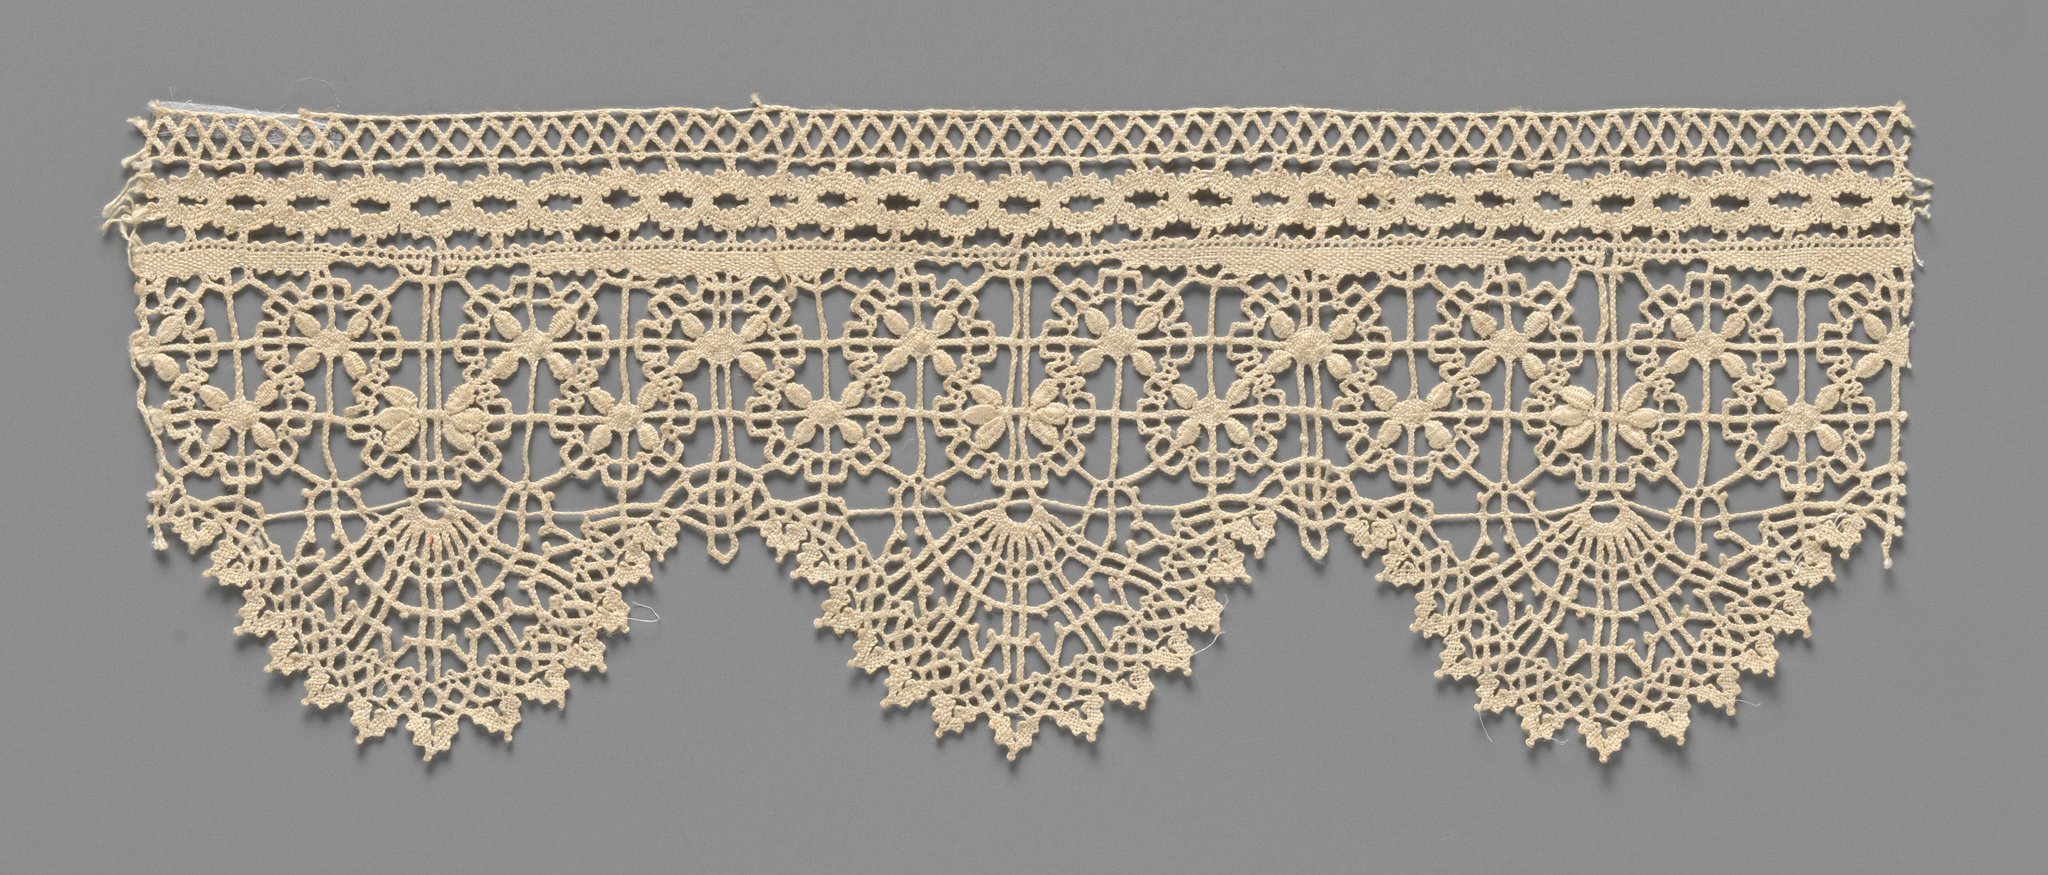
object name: strip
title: Strook kloskant met met gierstkorrelblaadjes in vierkant raster en waaiervormige schulpen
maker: Anonymous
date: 1925-1936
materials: linen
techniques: lace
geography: italy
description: Strook naturelkleurige Genuese kloskant. Het zich herhalende en symmetrische patroon bestaat uit een gevlochten raster van drie rijen vierkantjes met daarin een aaneenschakeling van waaiervormige motieven. Deze waaiertjes, of halve rozetten, zijn afwisselend hangend en staand gepositioneerd en hebben een ovaal centrum waar vier of zes blaadjes omheen staan. De blaadjes zijn gemaakt in vormslag. De schulpenrand langs de onderzijde van de strook bestaat uit grotere waaiervormige schulpen. Deze zijn grotendeels opgebouwd uit vlechten, de kleine puntige lobben aan de uiteinden zijn gemaakt in linnenslag. De bovenzijde van de strook is recht afgewerkt met een sierrand die bestaat uit een rij aaneengeschakelde opengewerkte ovalen in linnenslag en daarboven een rechte rand met een gevlochten ruitvormig raster. Het patroon is gemaakt naar zeventiende-eeuws voorbeeld.